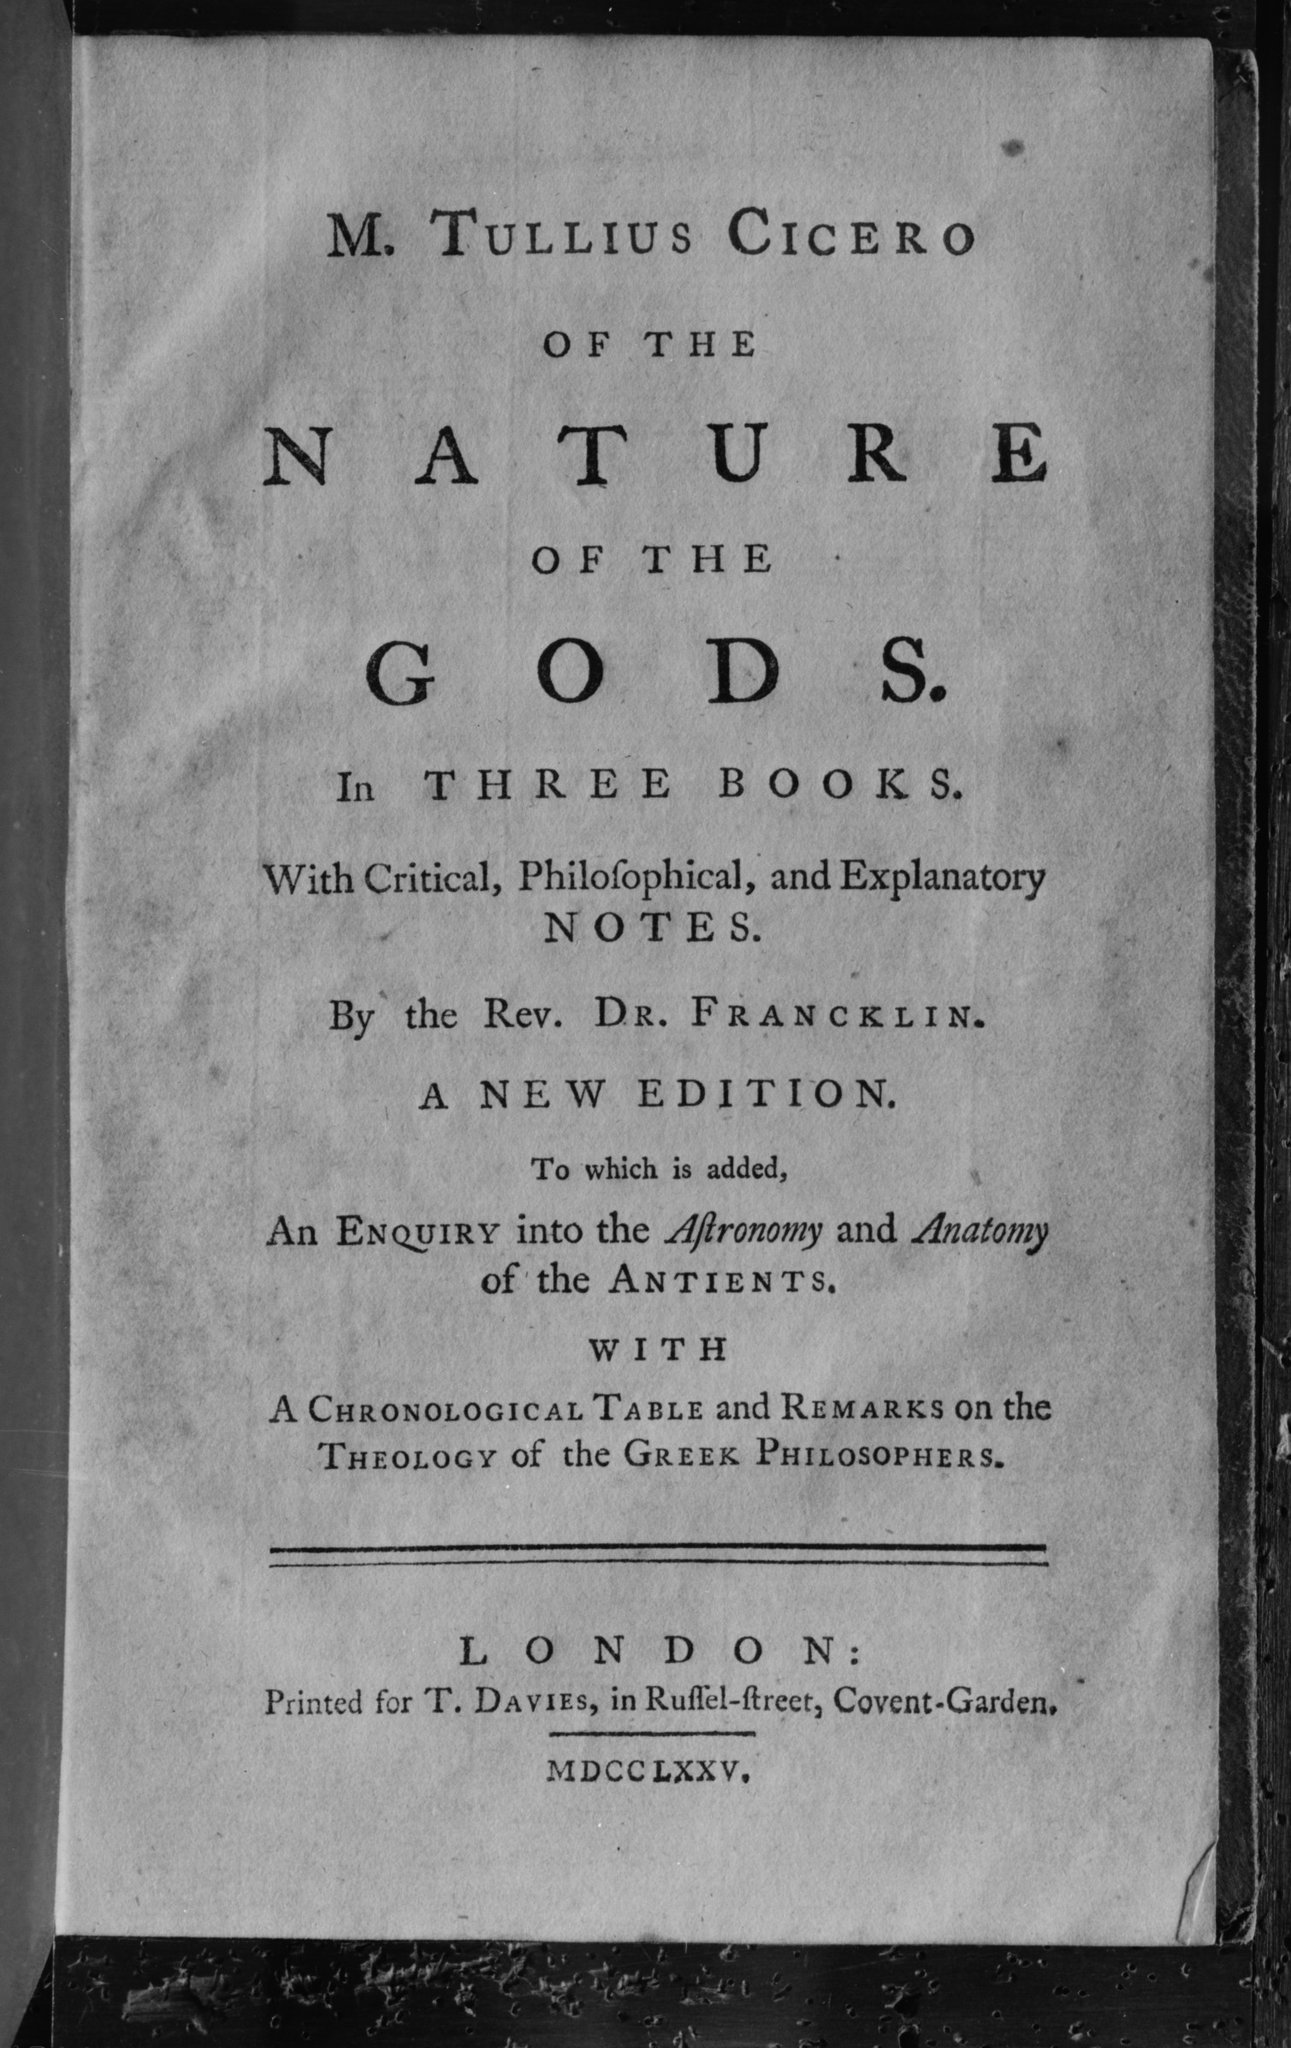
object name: book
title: Book: Of the Nature of the Gods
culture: british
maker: marcus tullius cicero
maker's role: author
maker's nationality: roman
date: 1775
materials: paper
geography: england